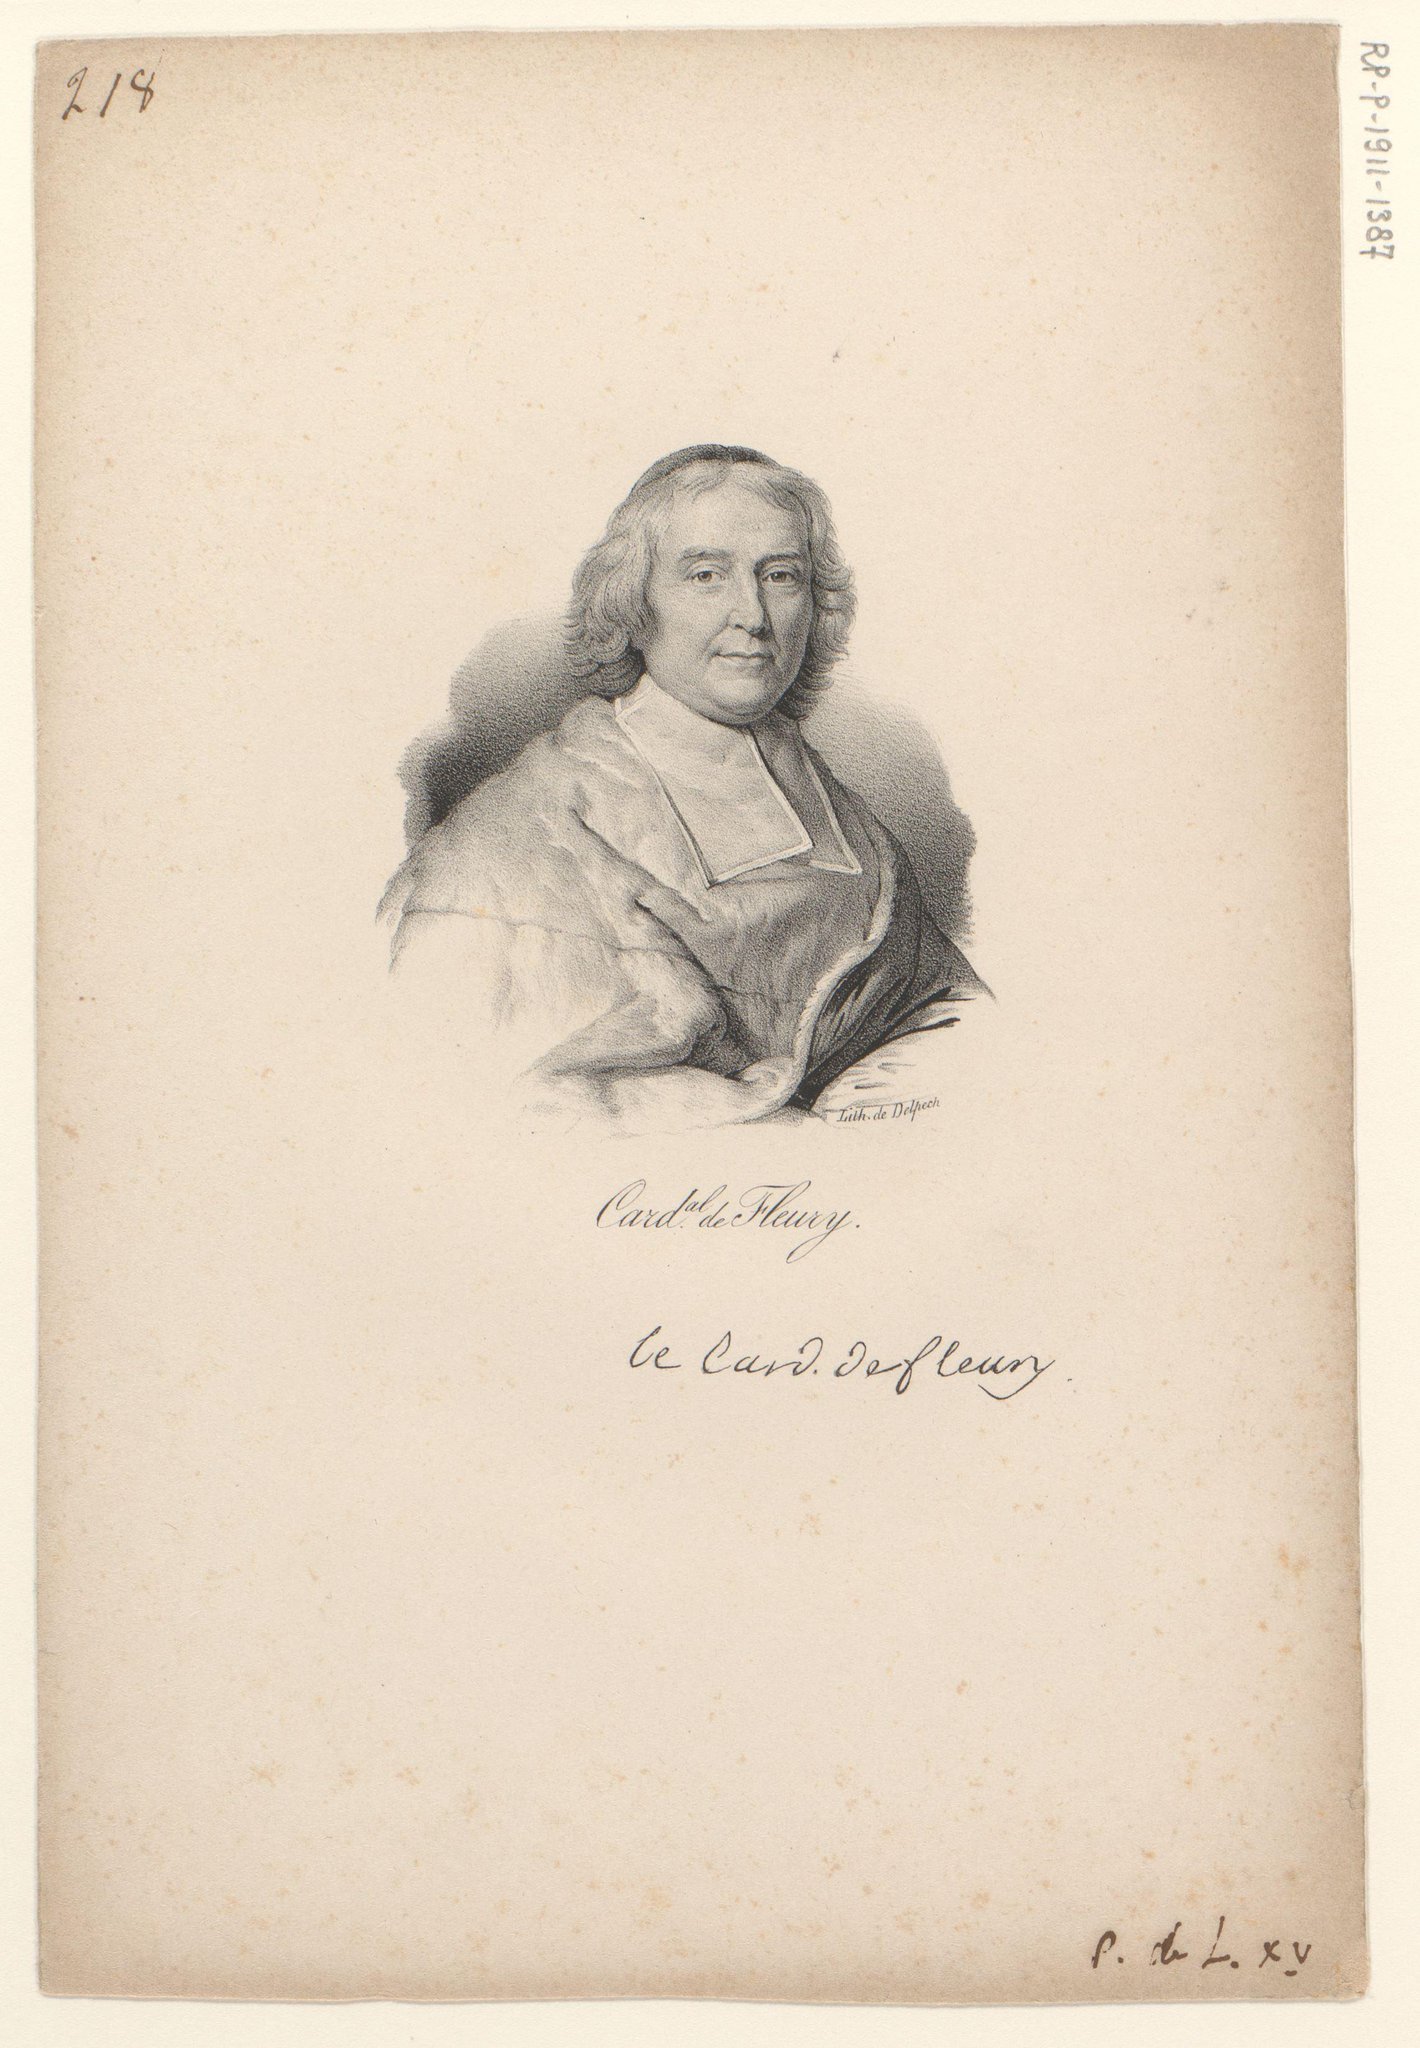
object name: print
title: Card.al de Fleury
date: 1818-1842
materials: paper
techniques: lithograph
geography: paris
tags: historical persons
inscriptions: collector's mark: Lugt 2228a